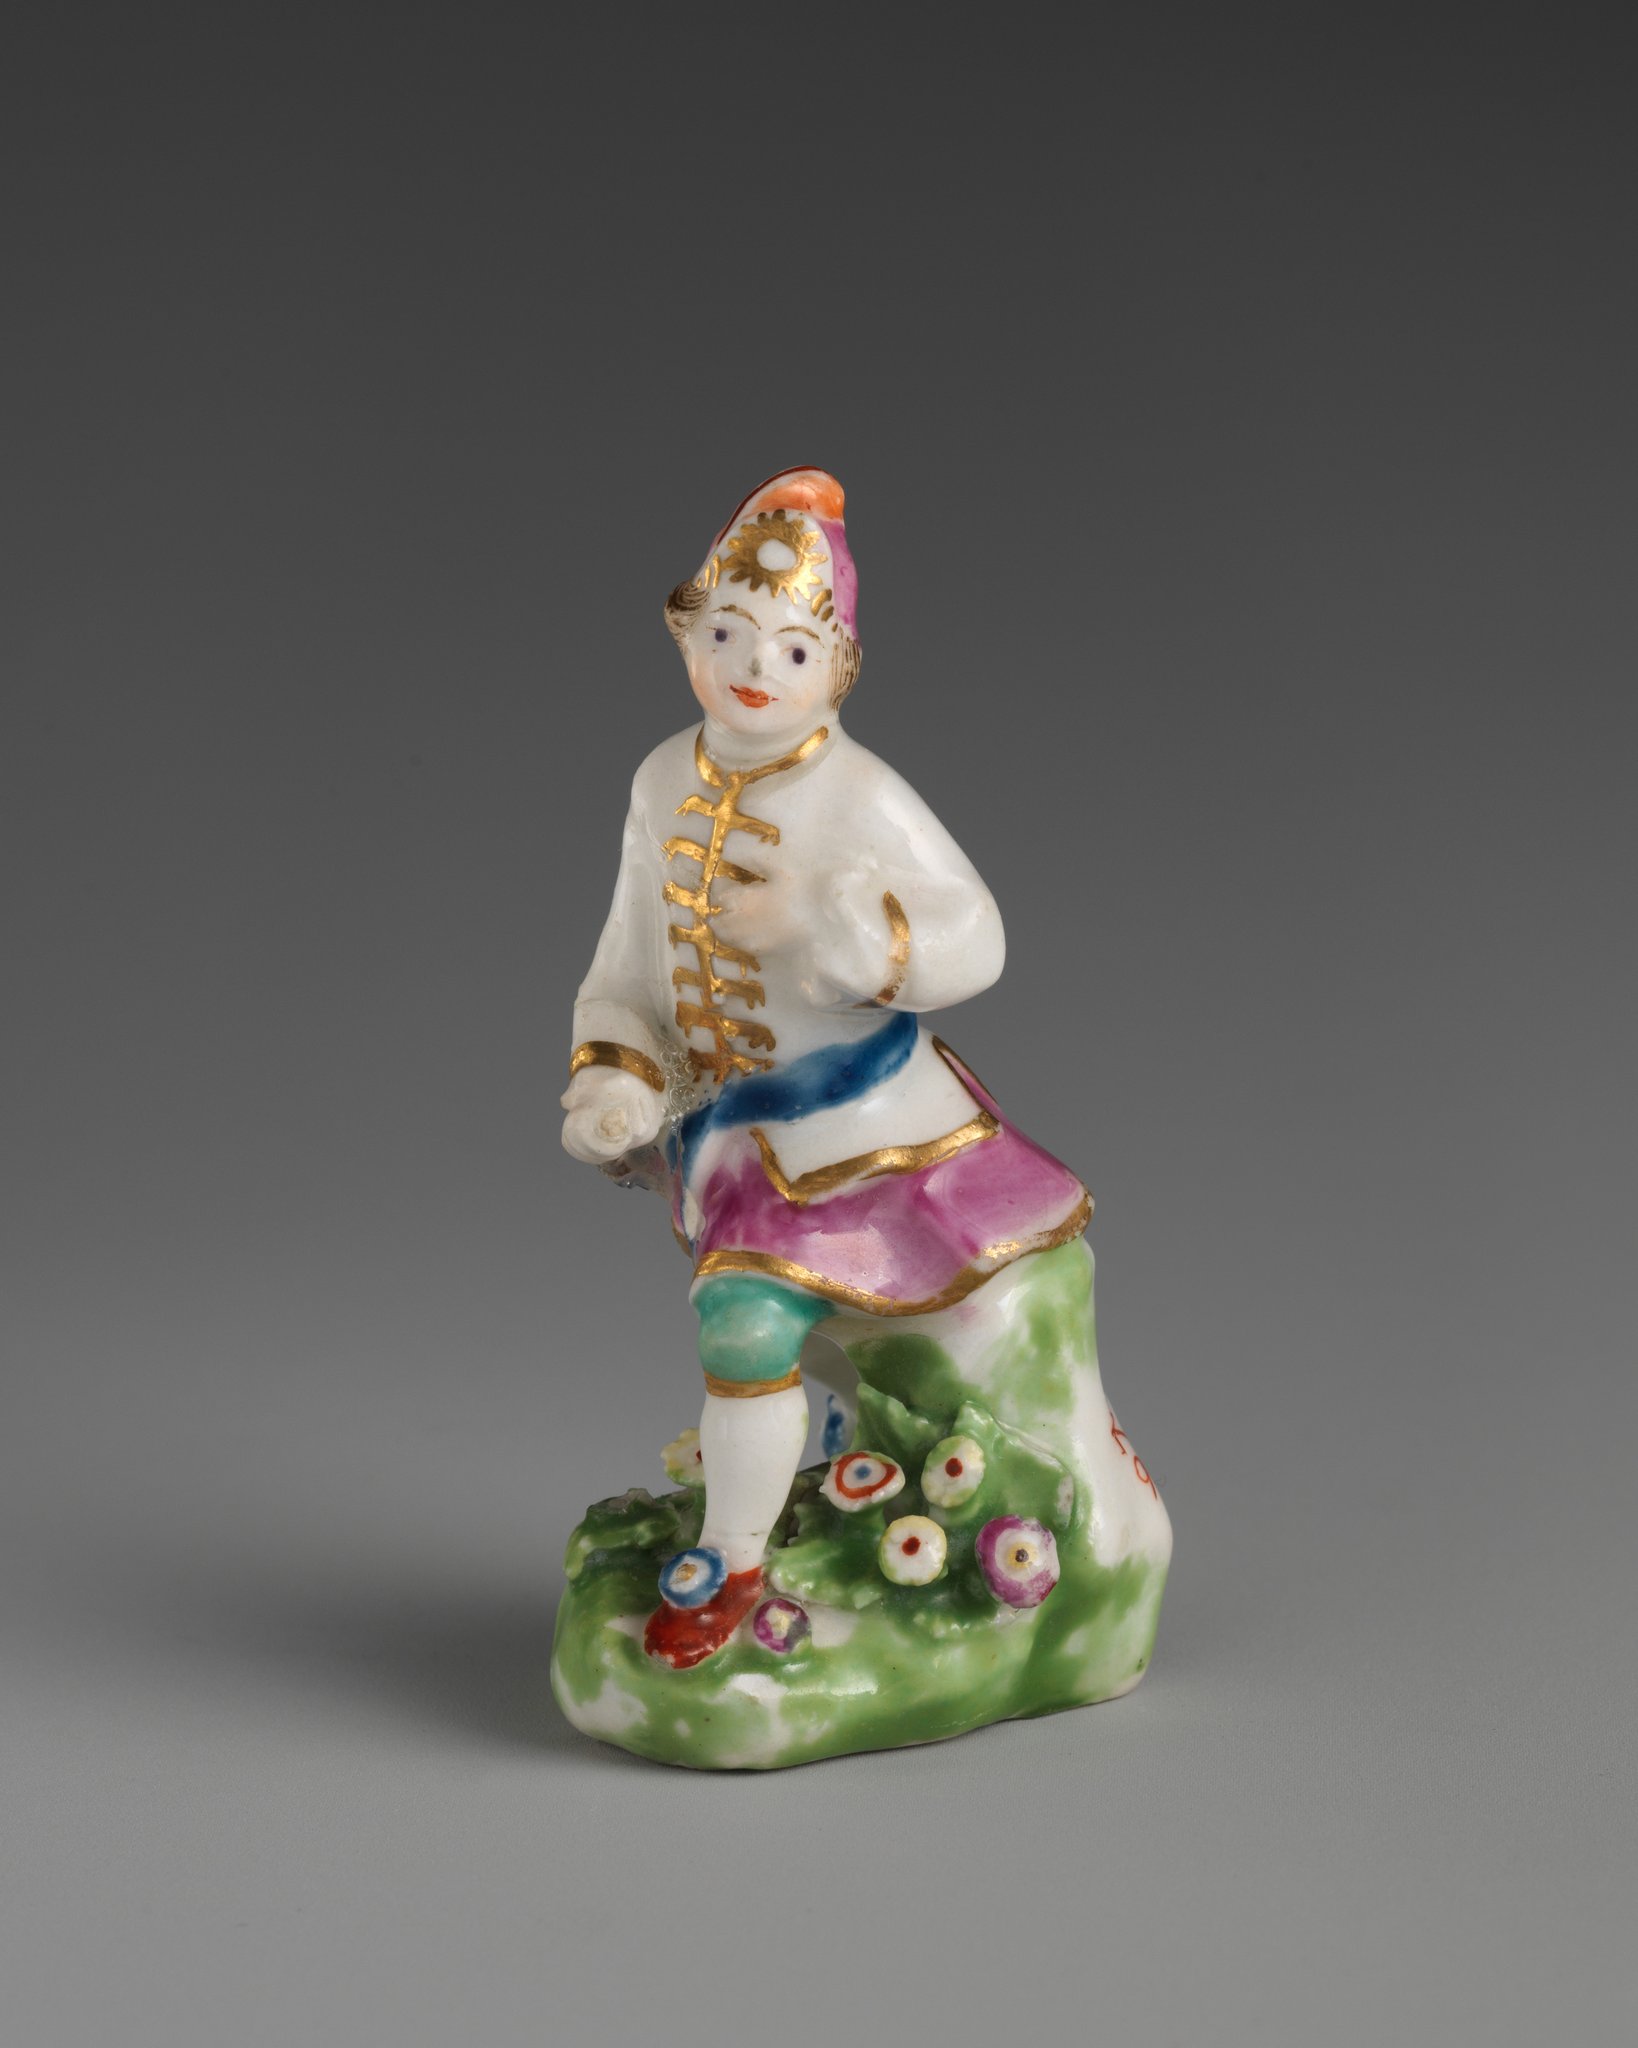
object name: toy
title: Highlander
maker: derby porcelain manufactory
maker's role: factory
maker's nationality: british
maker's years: 1751-1785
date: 1765-1768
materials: soft paste porcelain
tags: men